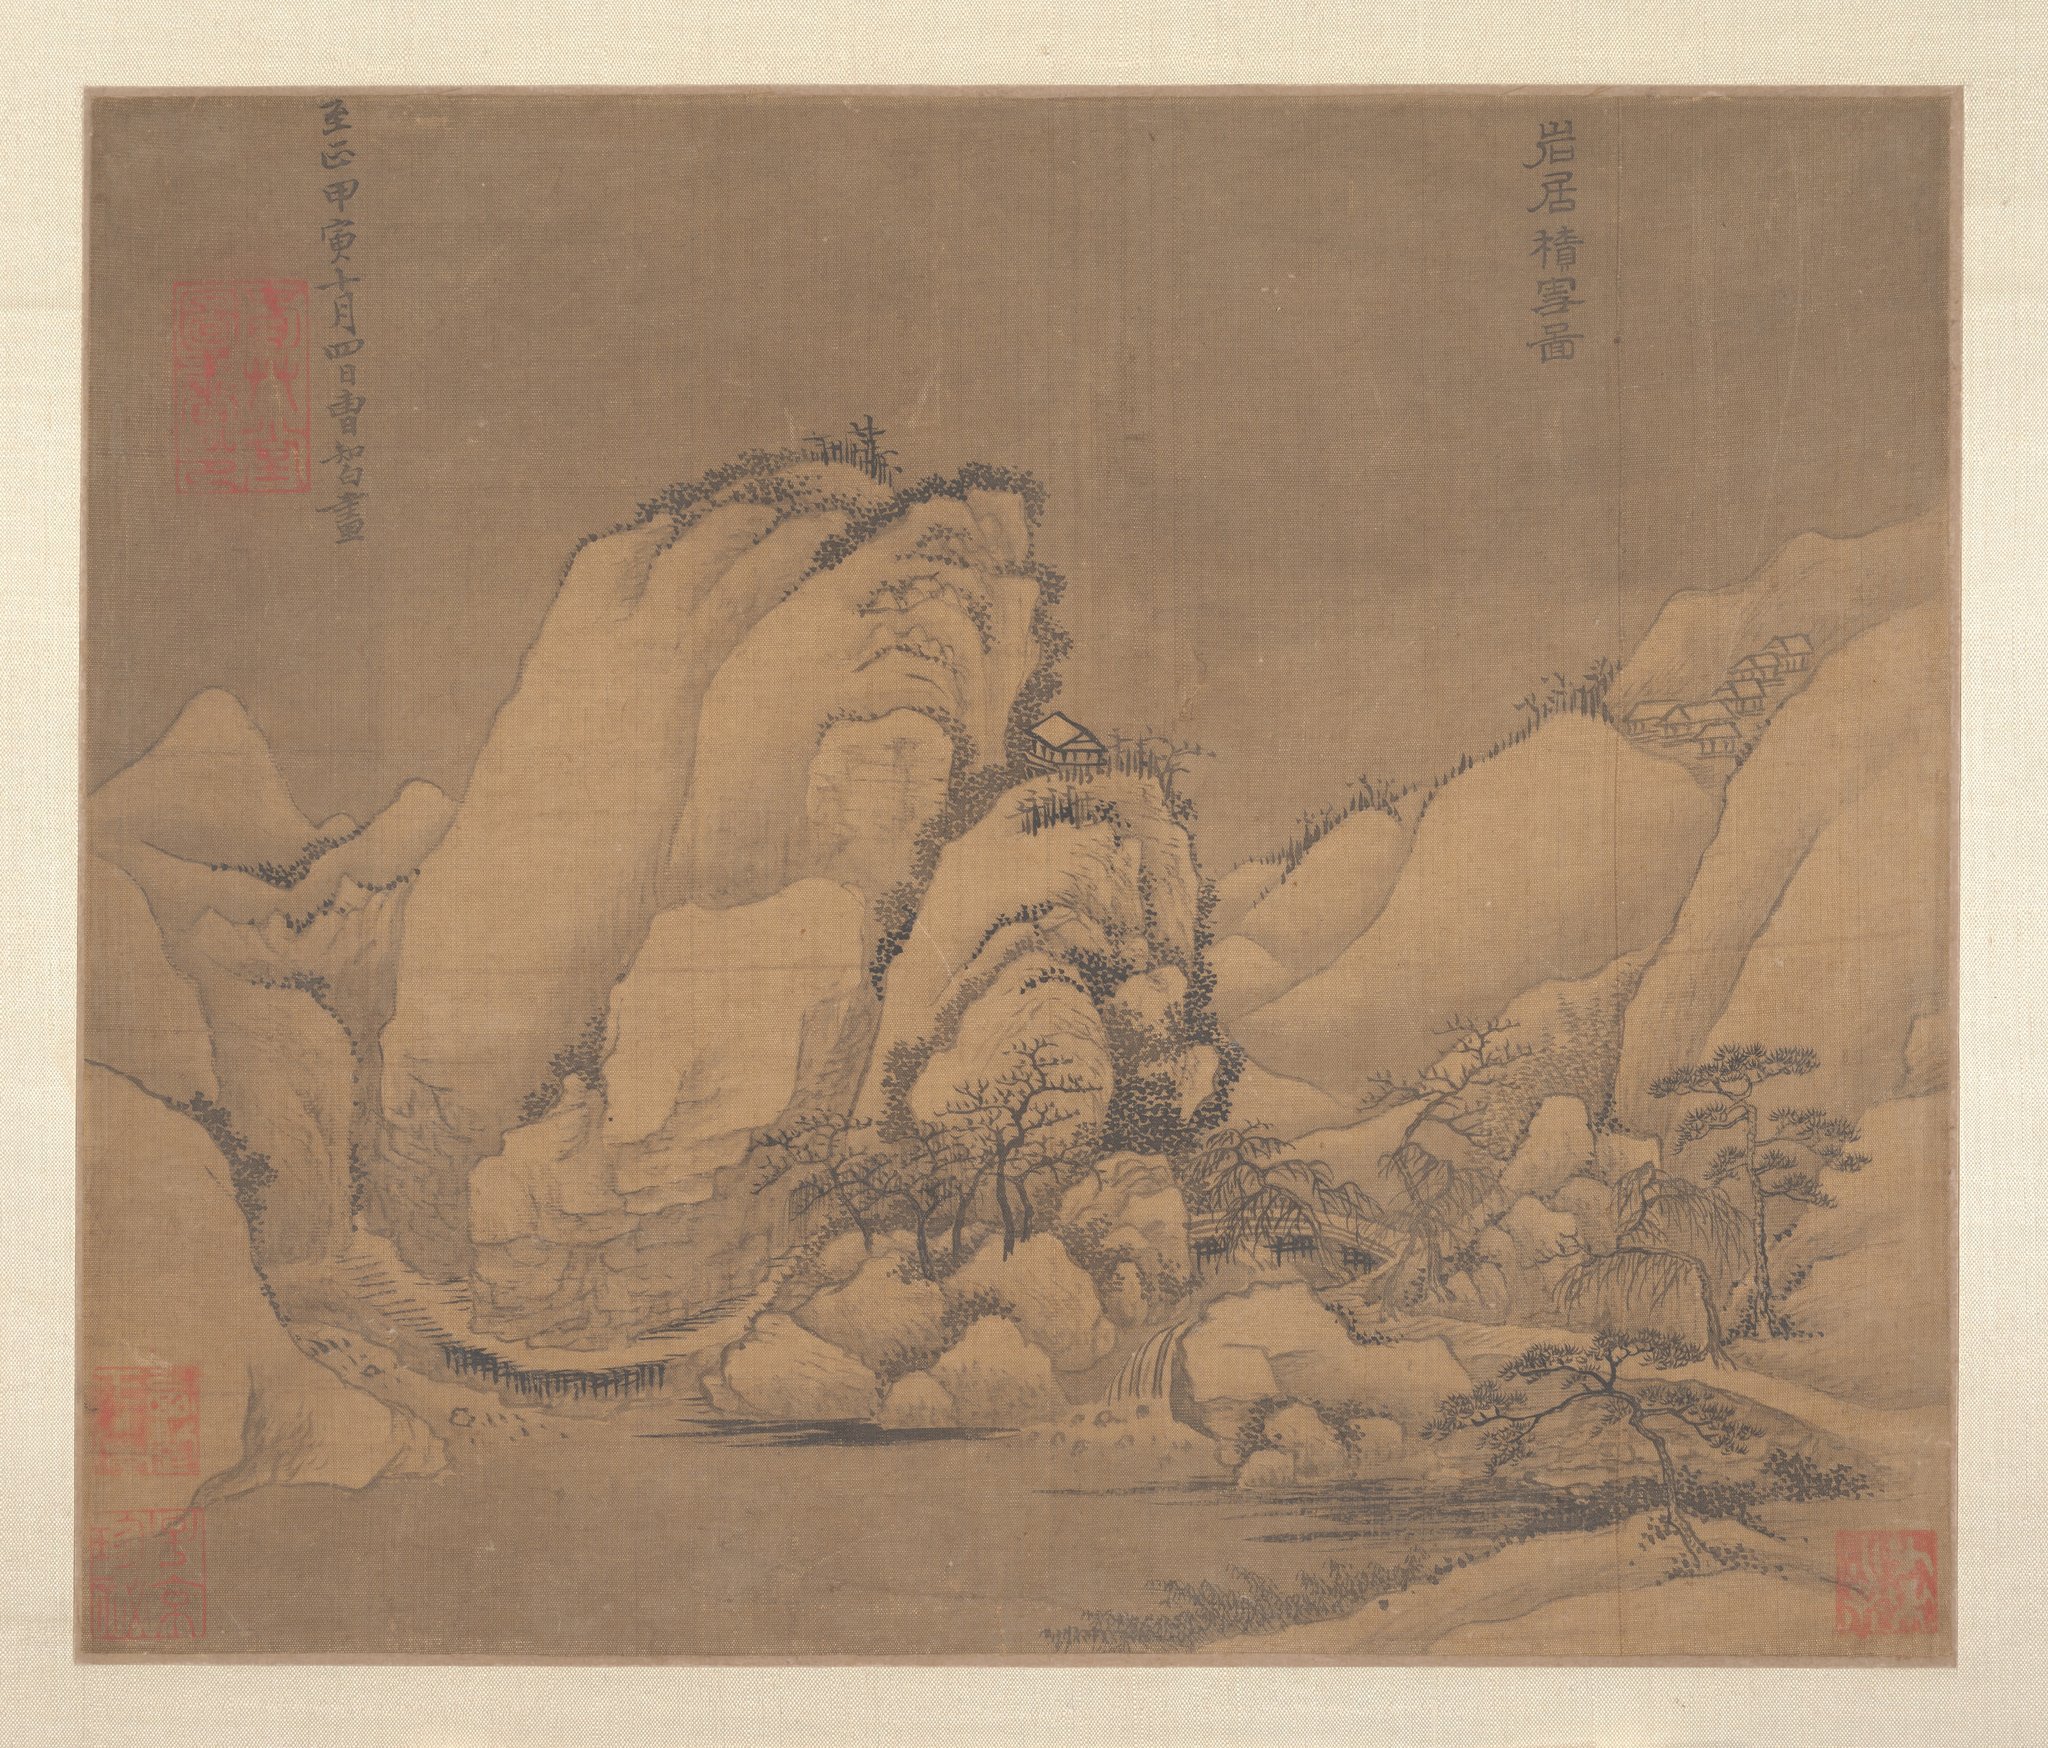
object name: album leaf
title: Landscape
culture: chinese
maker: unidentified artist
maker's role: artist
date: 1644-1911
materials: ink, silk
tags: mountains,landscapes